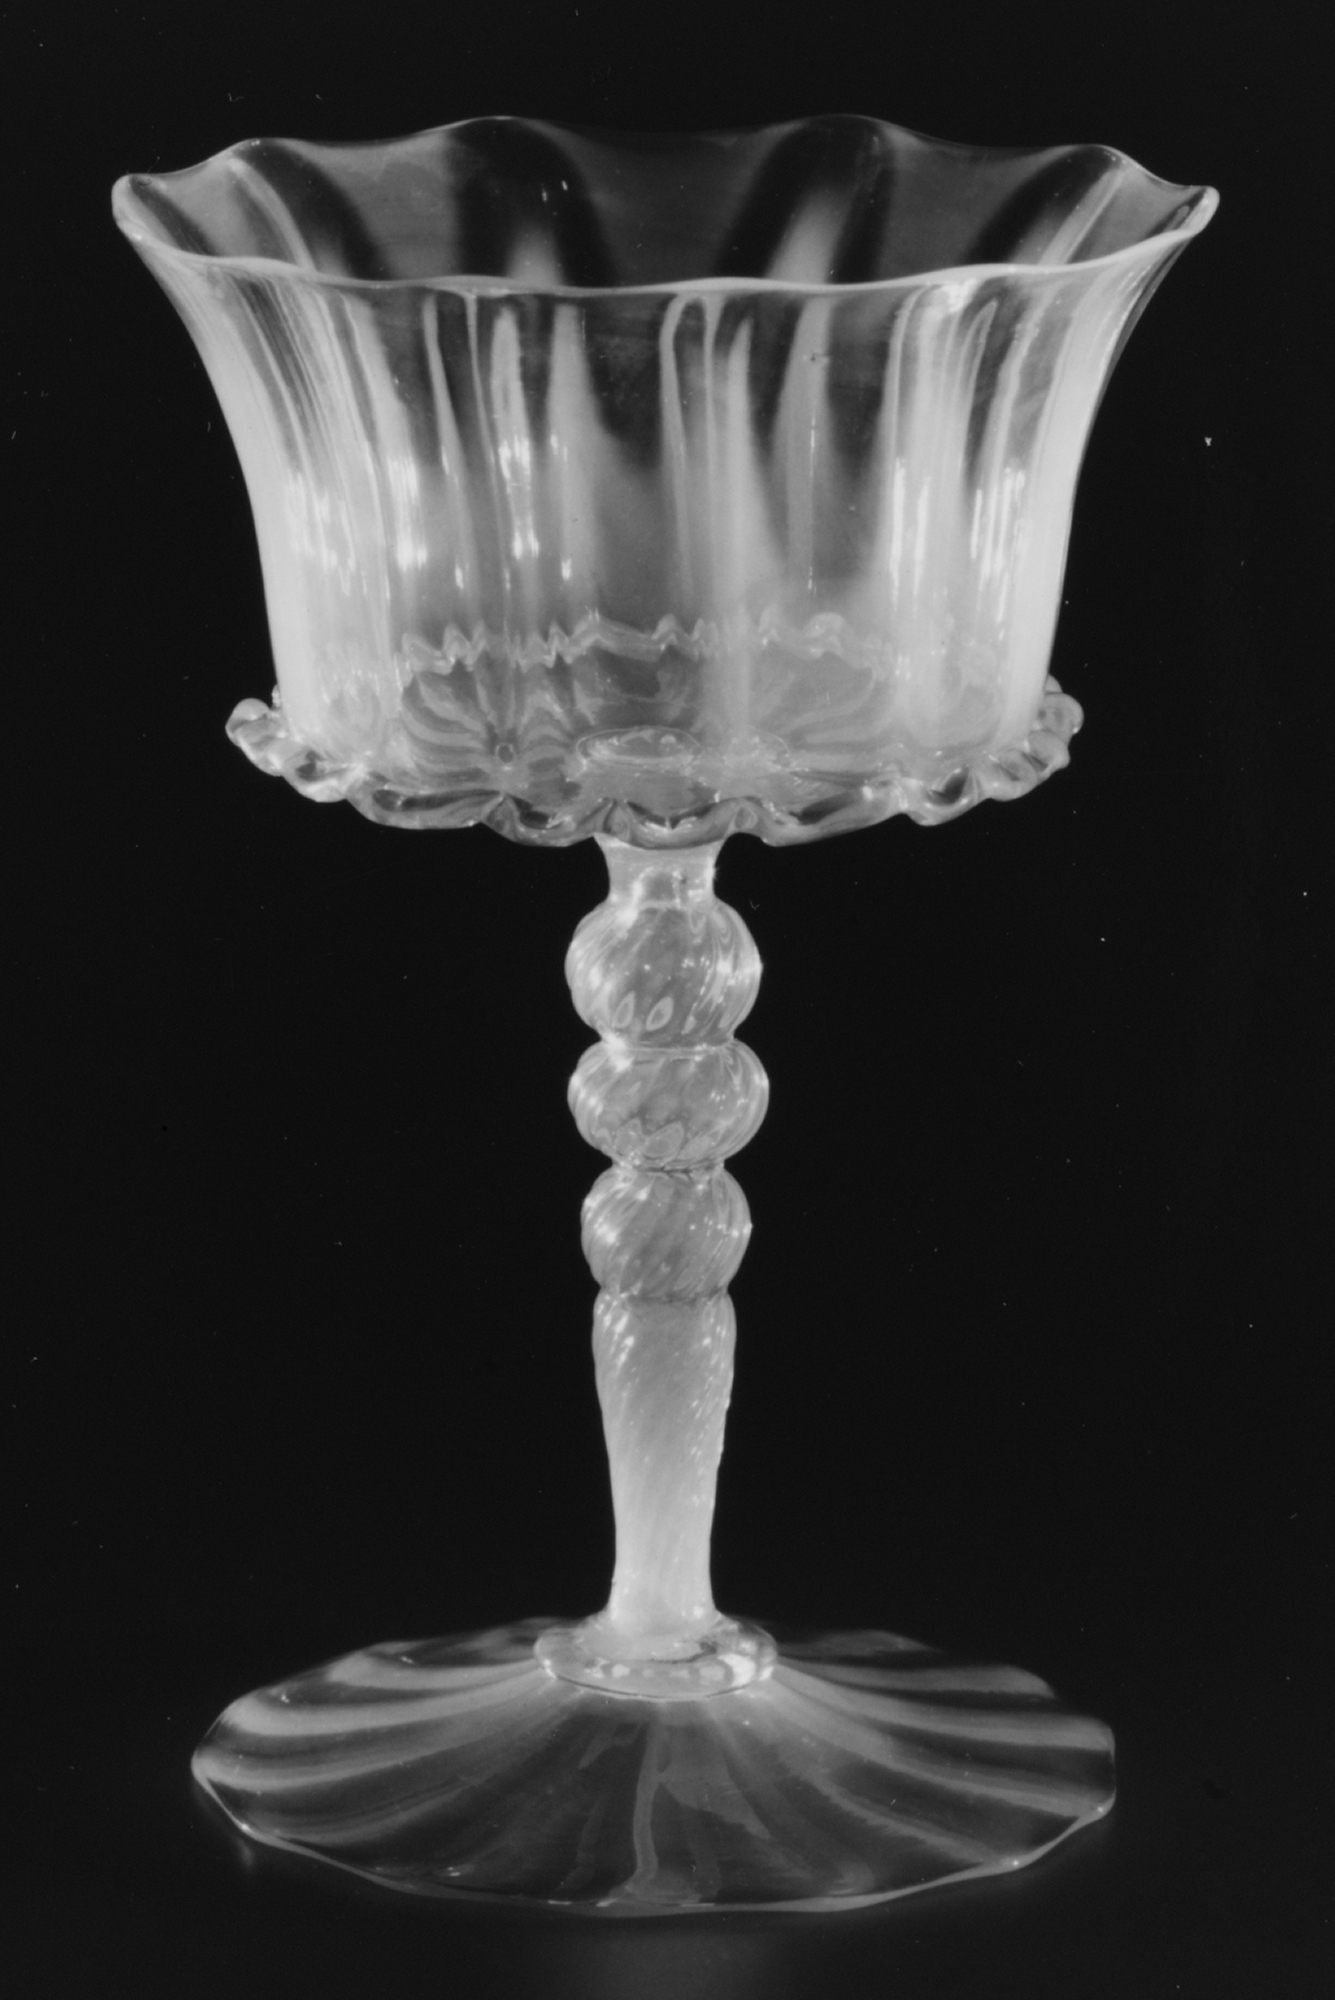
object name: dessert glass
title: Dessert glass(?)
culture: italian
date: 1667-1700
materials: glass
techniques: glassblowing, molding